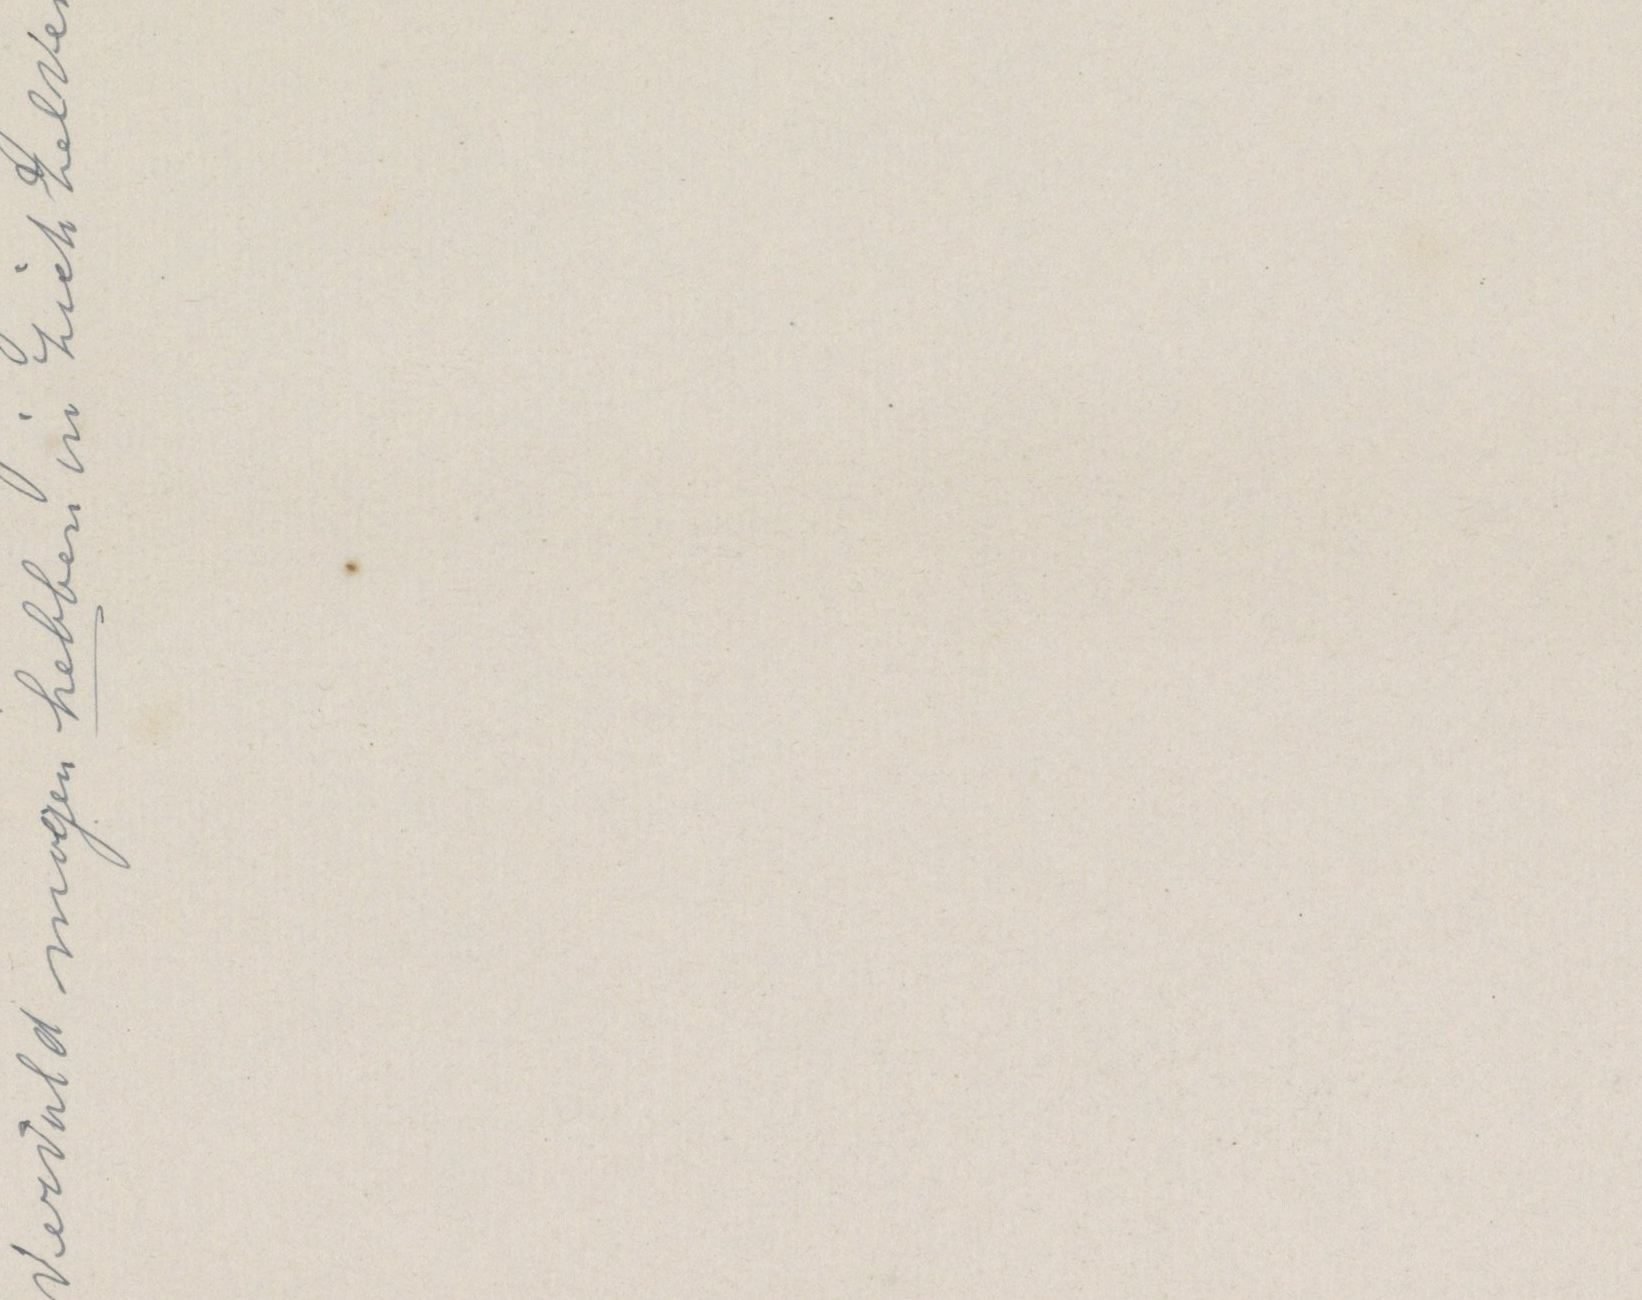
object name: sketchbook leaf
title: Bijbelverzen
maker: marie jordan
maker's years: 1866-1948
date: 1906-1948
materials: ink, paper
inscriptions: annotation: ‘[...]’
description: Pagina 20 uit een schetsboek met 31 bladen.